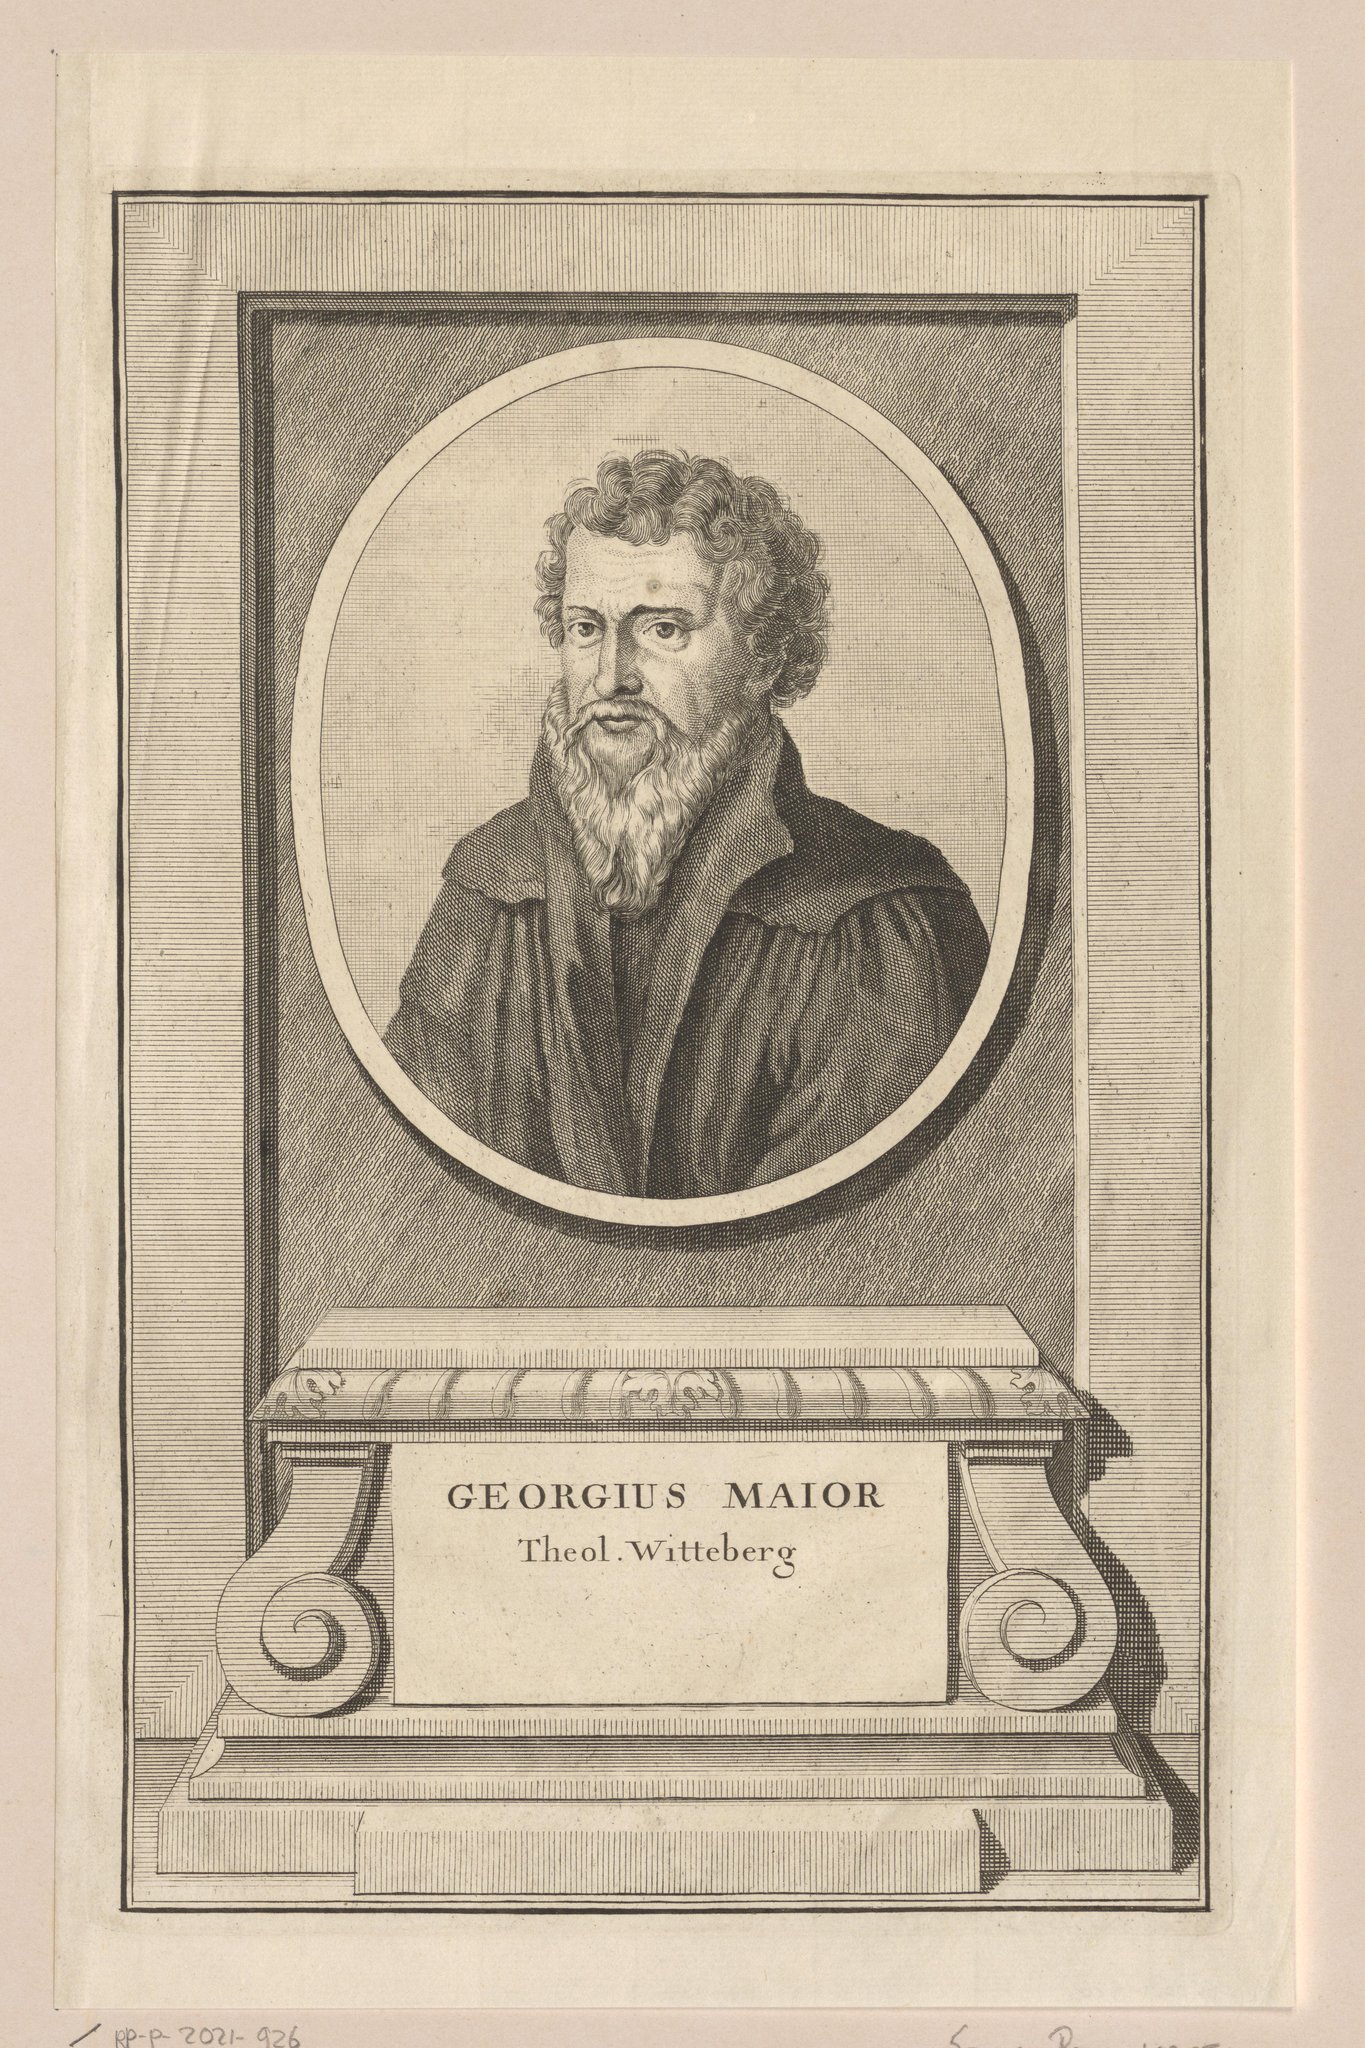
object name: print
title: Portret van Georg Major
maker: Anonymous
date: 1600-1700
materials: paper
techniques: engraving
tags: historical persons, mistress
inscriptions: watermark